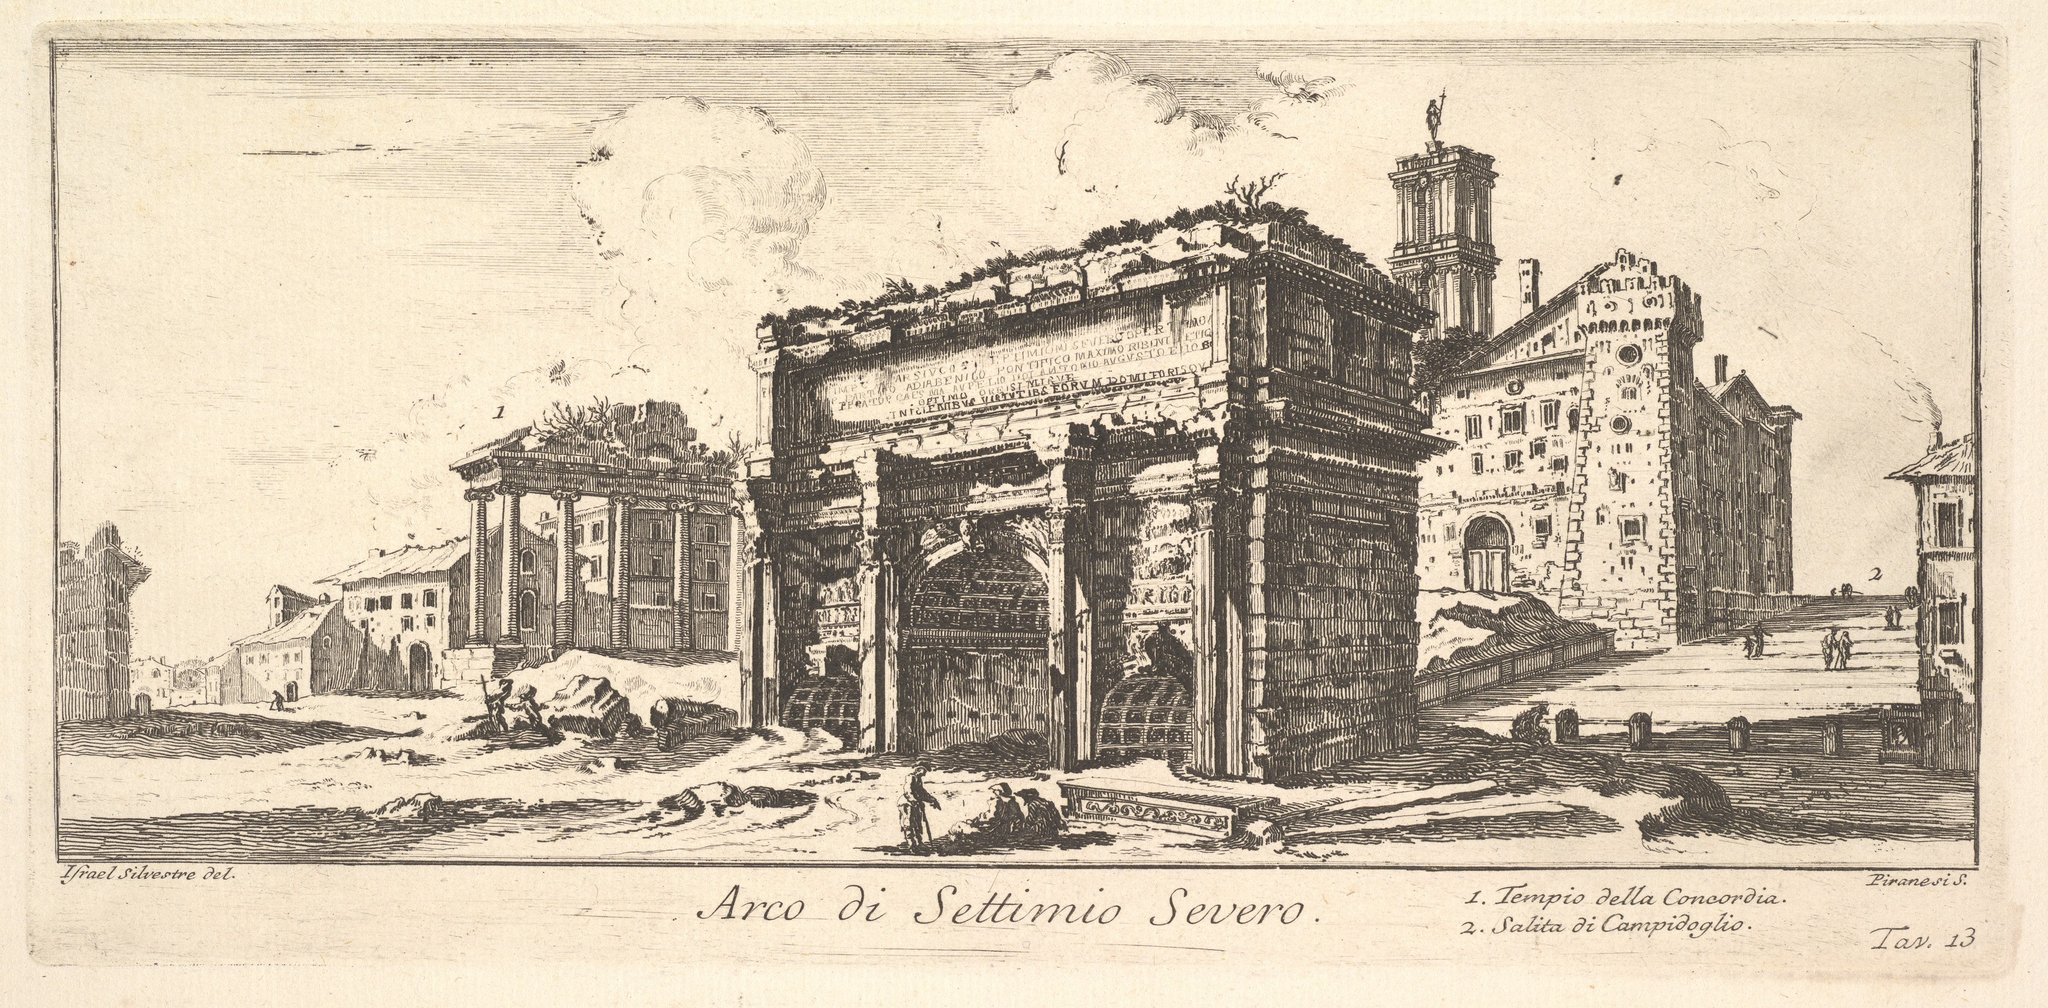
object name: print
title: Plate 13: Arch of Settimius Severus 1. Temple of Concord. 2. Ascent to the Capitoline Hill (Arco di Settimio Severo. 1. Tempio della Concordia. 2. Salita di Campidoglio.), from "Antichità Romane de' Tempi della Repubblica, e de' primi Imperatori"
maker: giovanni battista piranesi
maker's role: artist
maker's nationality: italian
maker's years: 1720-1778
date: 1748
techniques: etching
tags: buildings,ruins